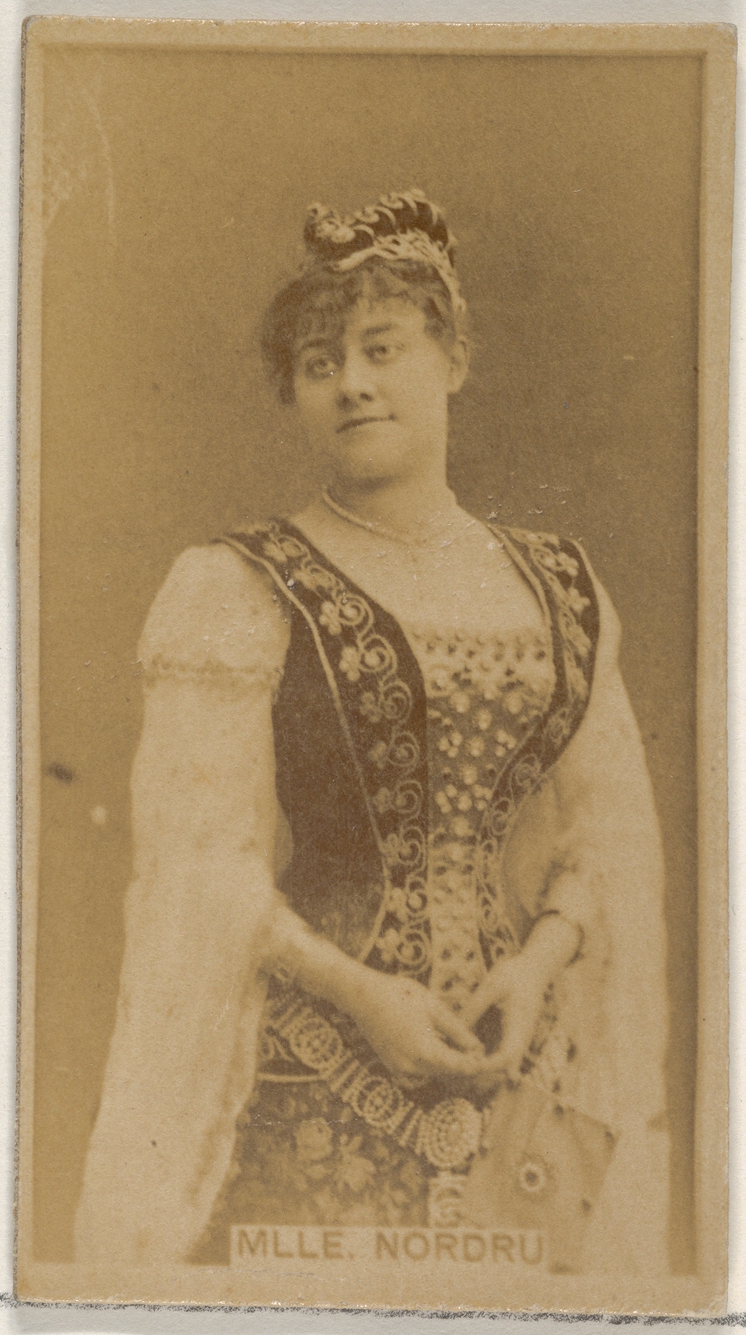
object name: photograph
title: Mlle. Nordrum, from the Actors and Actresses series (N45, Type 8) for Virginia Brights Cigarettes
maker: allen & ginter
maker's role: publisher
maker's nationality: american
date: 1888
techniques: albumen silver print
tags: portraits,women,actresses